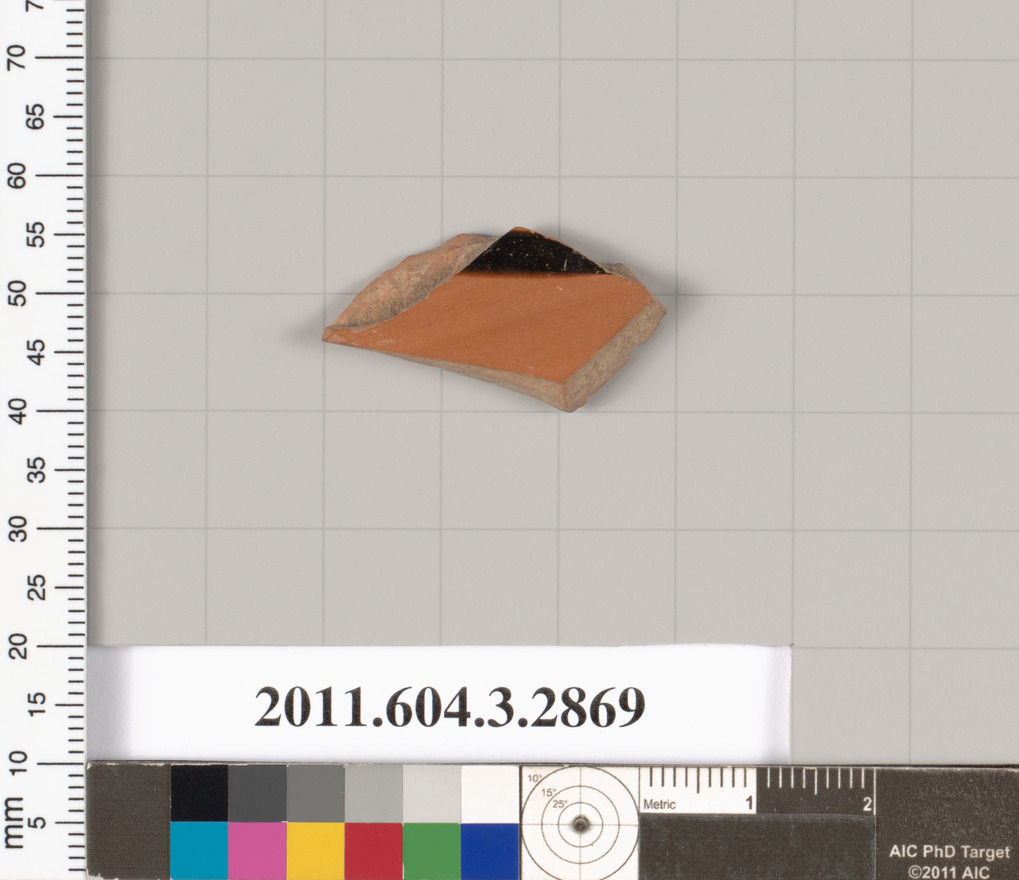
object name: kylix fragment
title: Terracotta fragment of a kylix (drinking cup)?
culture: greek, attic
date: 600-401 BCE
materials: terracotta